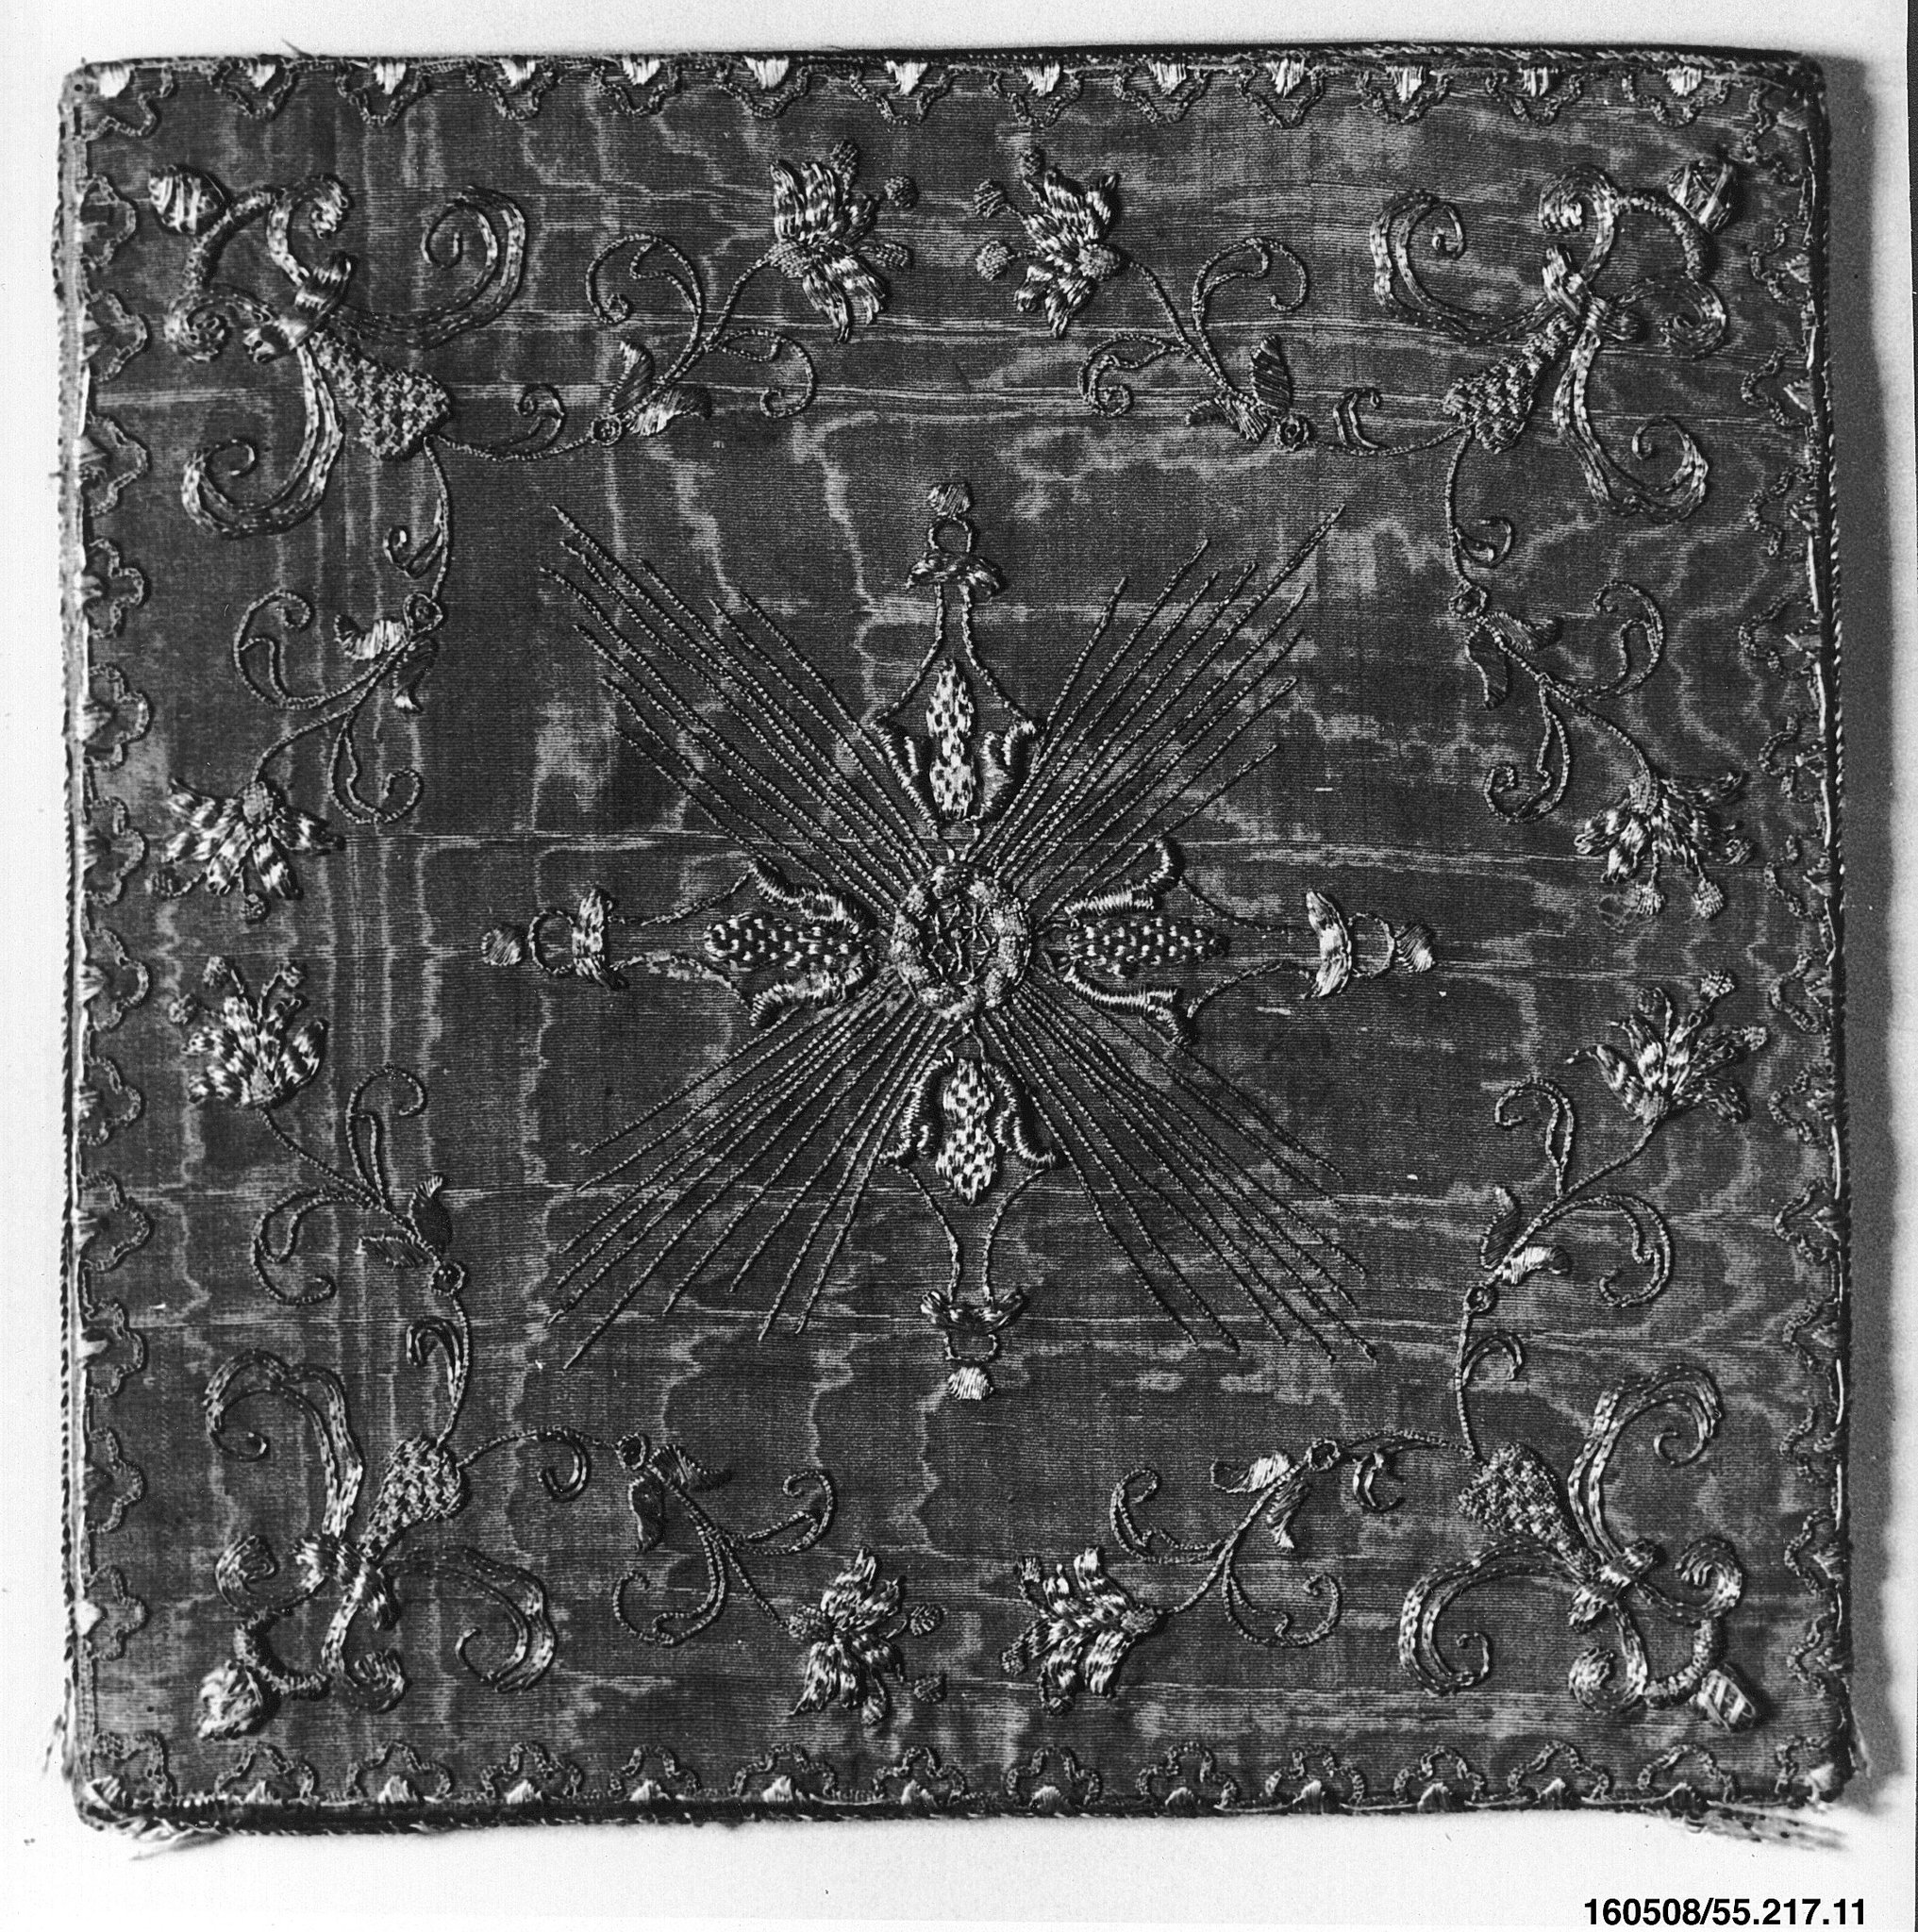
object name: burse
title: Burse (part of a set)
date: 1734-1766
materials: metal thread, silk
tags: flowers